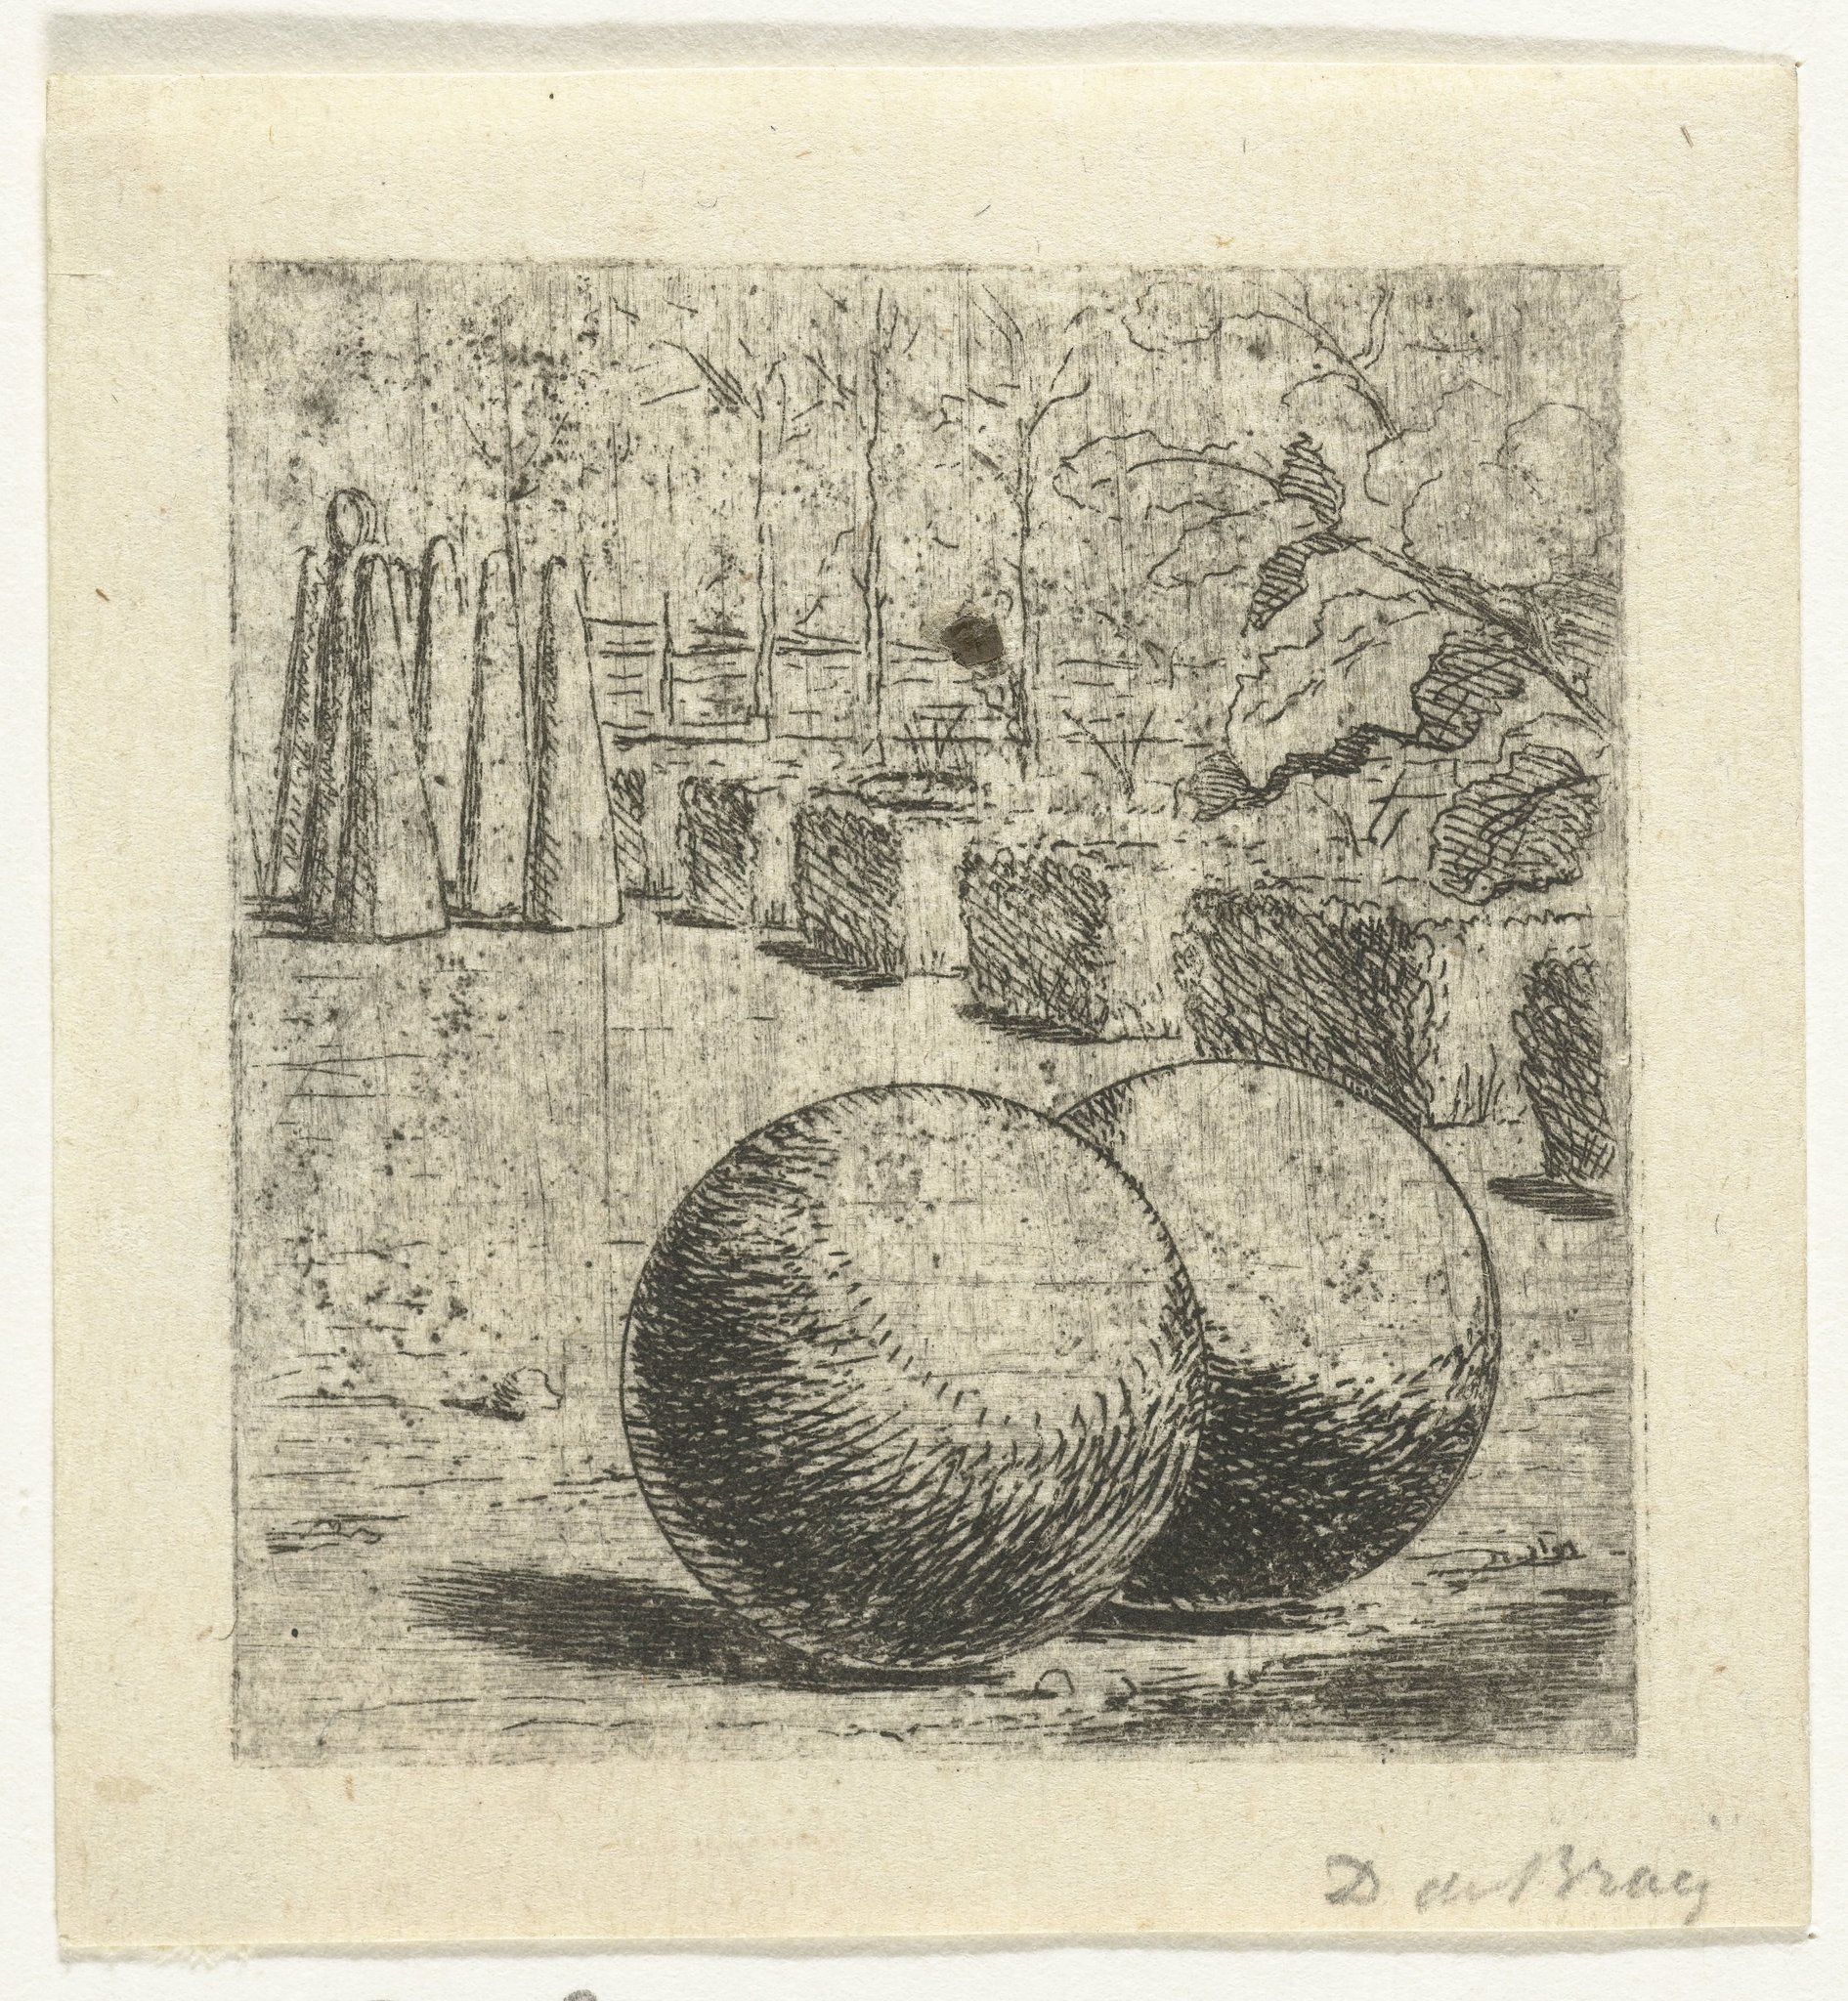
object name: print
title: Kegelspel met twee ballen en kegels op baan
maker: dirck de bray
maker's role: draughtsman, painter, print maker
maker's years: 1625-1694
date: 1645-1694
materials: paper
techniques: etching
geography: netherlands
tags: ninepins, skittles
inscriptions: collector's mark: Lugt 2228